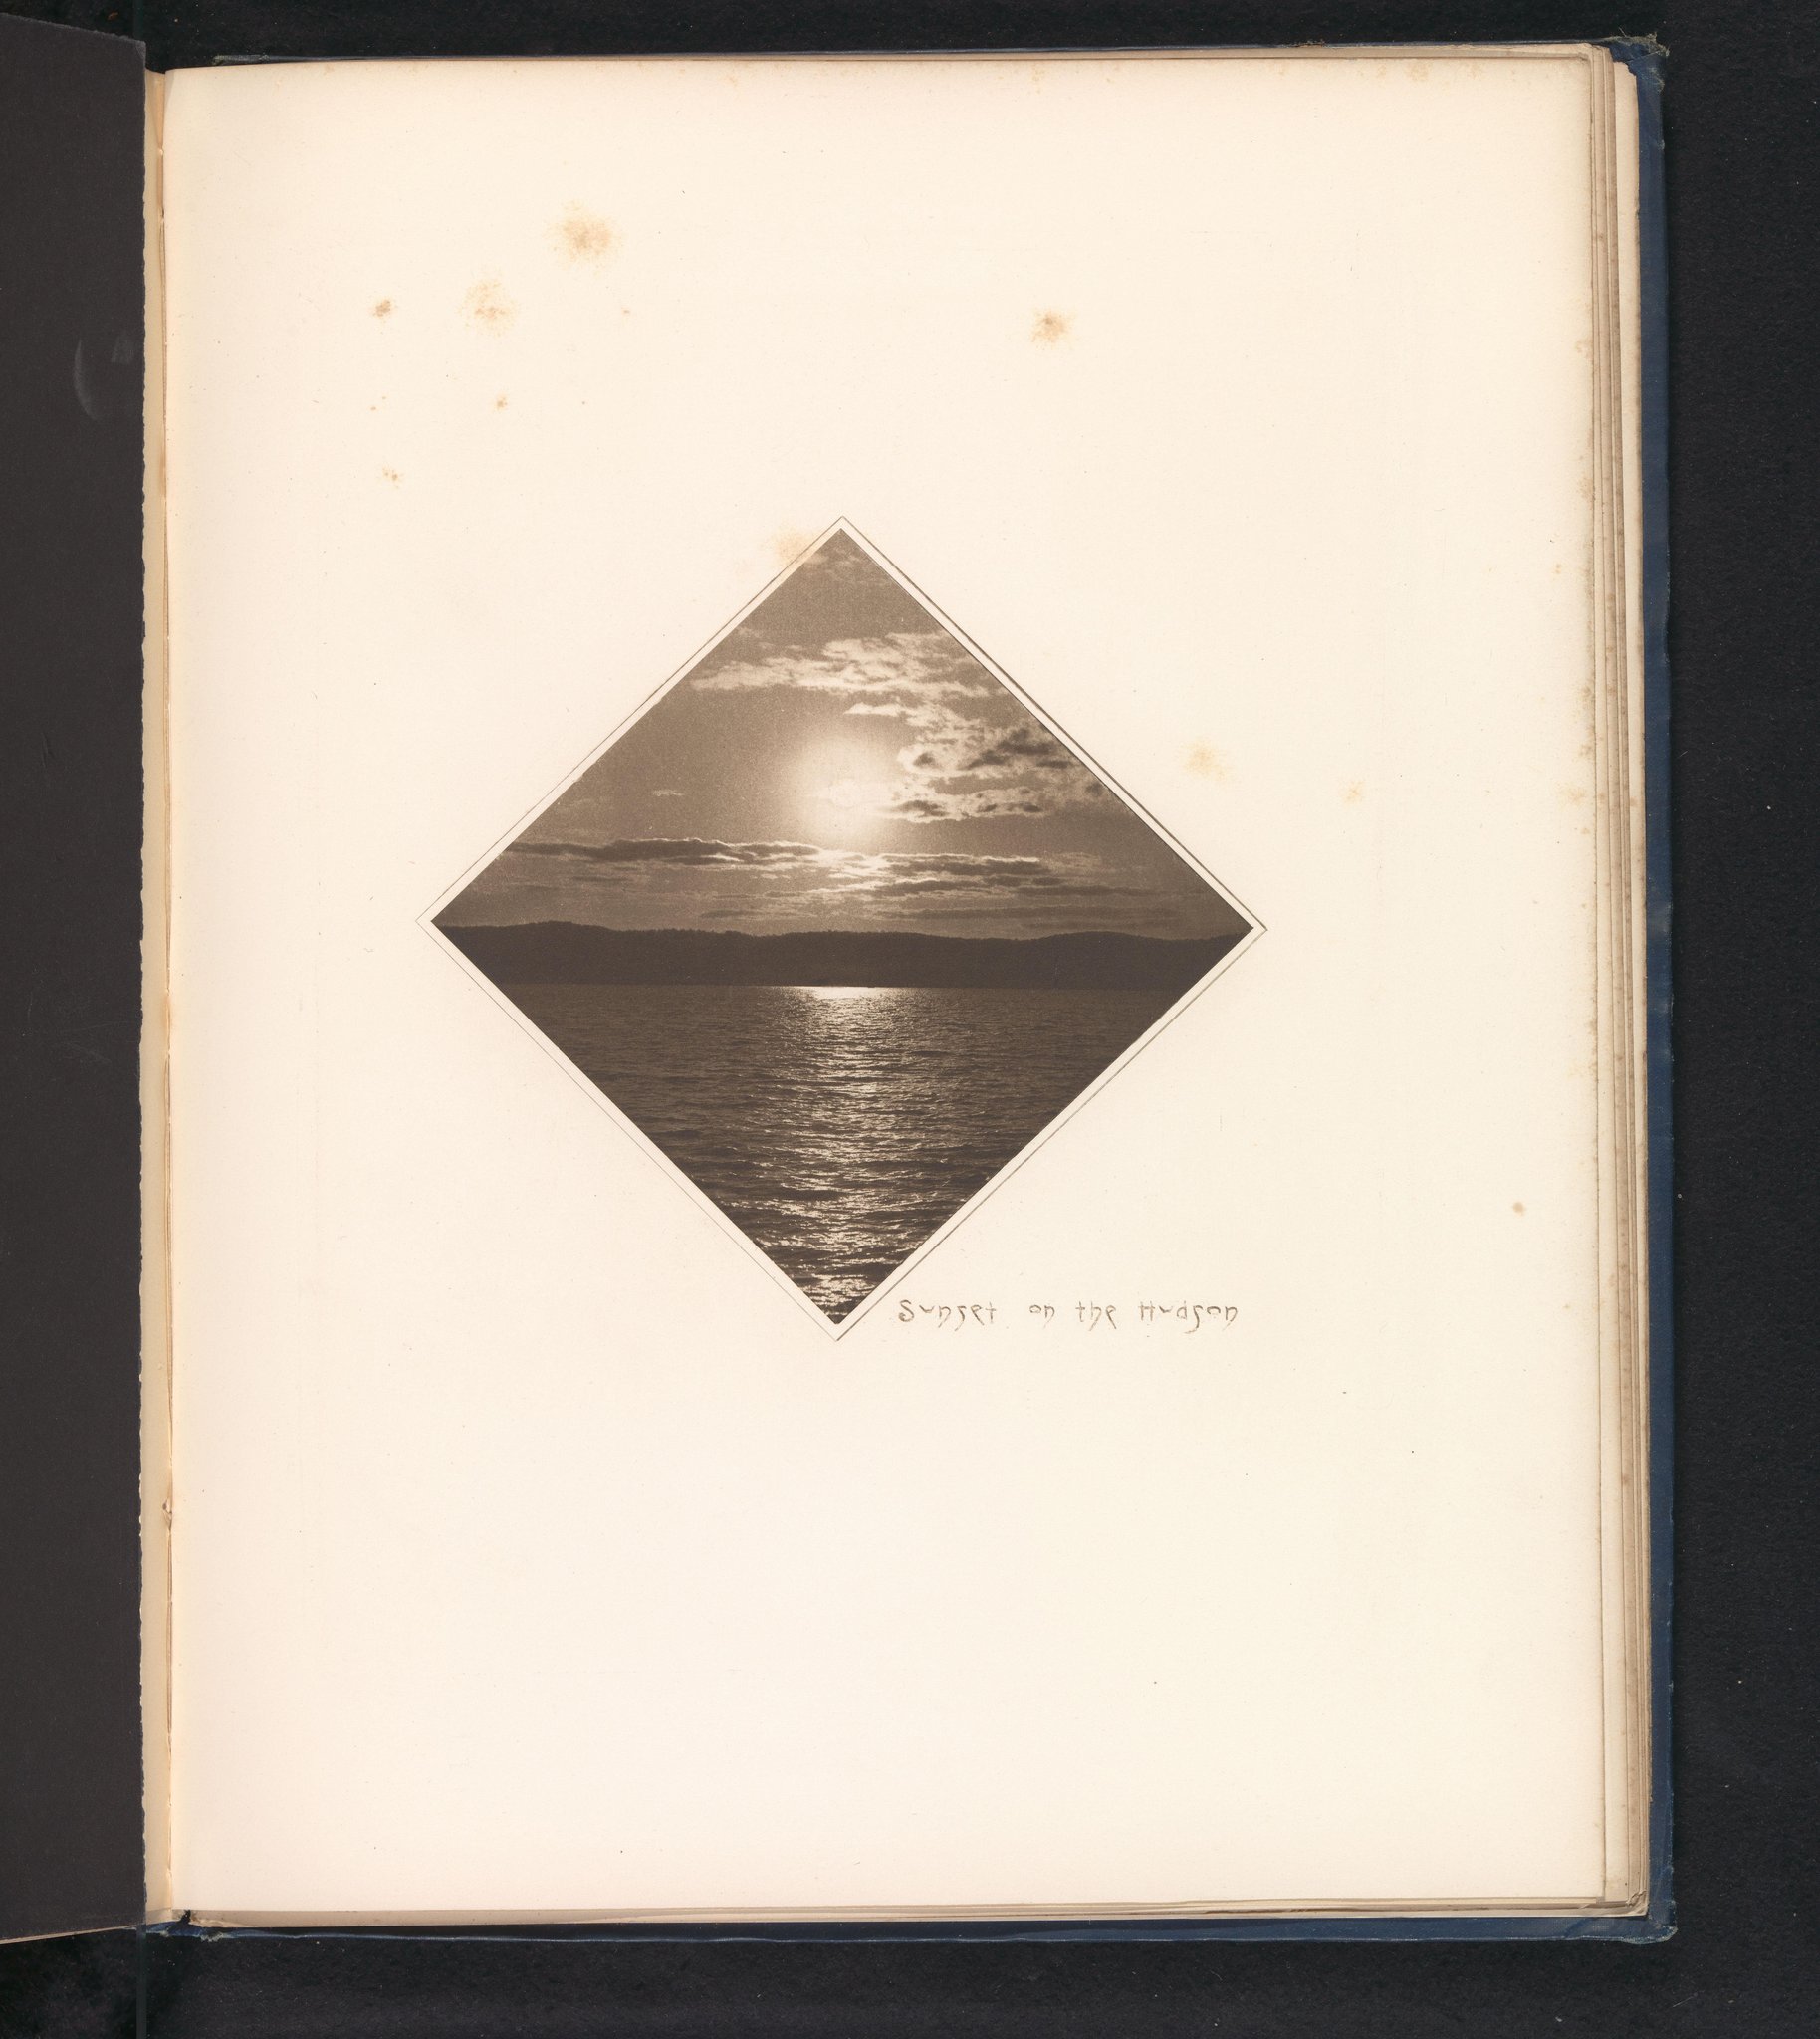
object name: photomechanical print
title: Zonsondergang boven de Hudson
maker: james leon williams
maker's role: fotograaf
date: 1882-1887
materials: paper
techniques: photoaquatint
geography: new york city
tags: river, sunset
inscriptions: inscription: ‘Sunset on the Hudson’